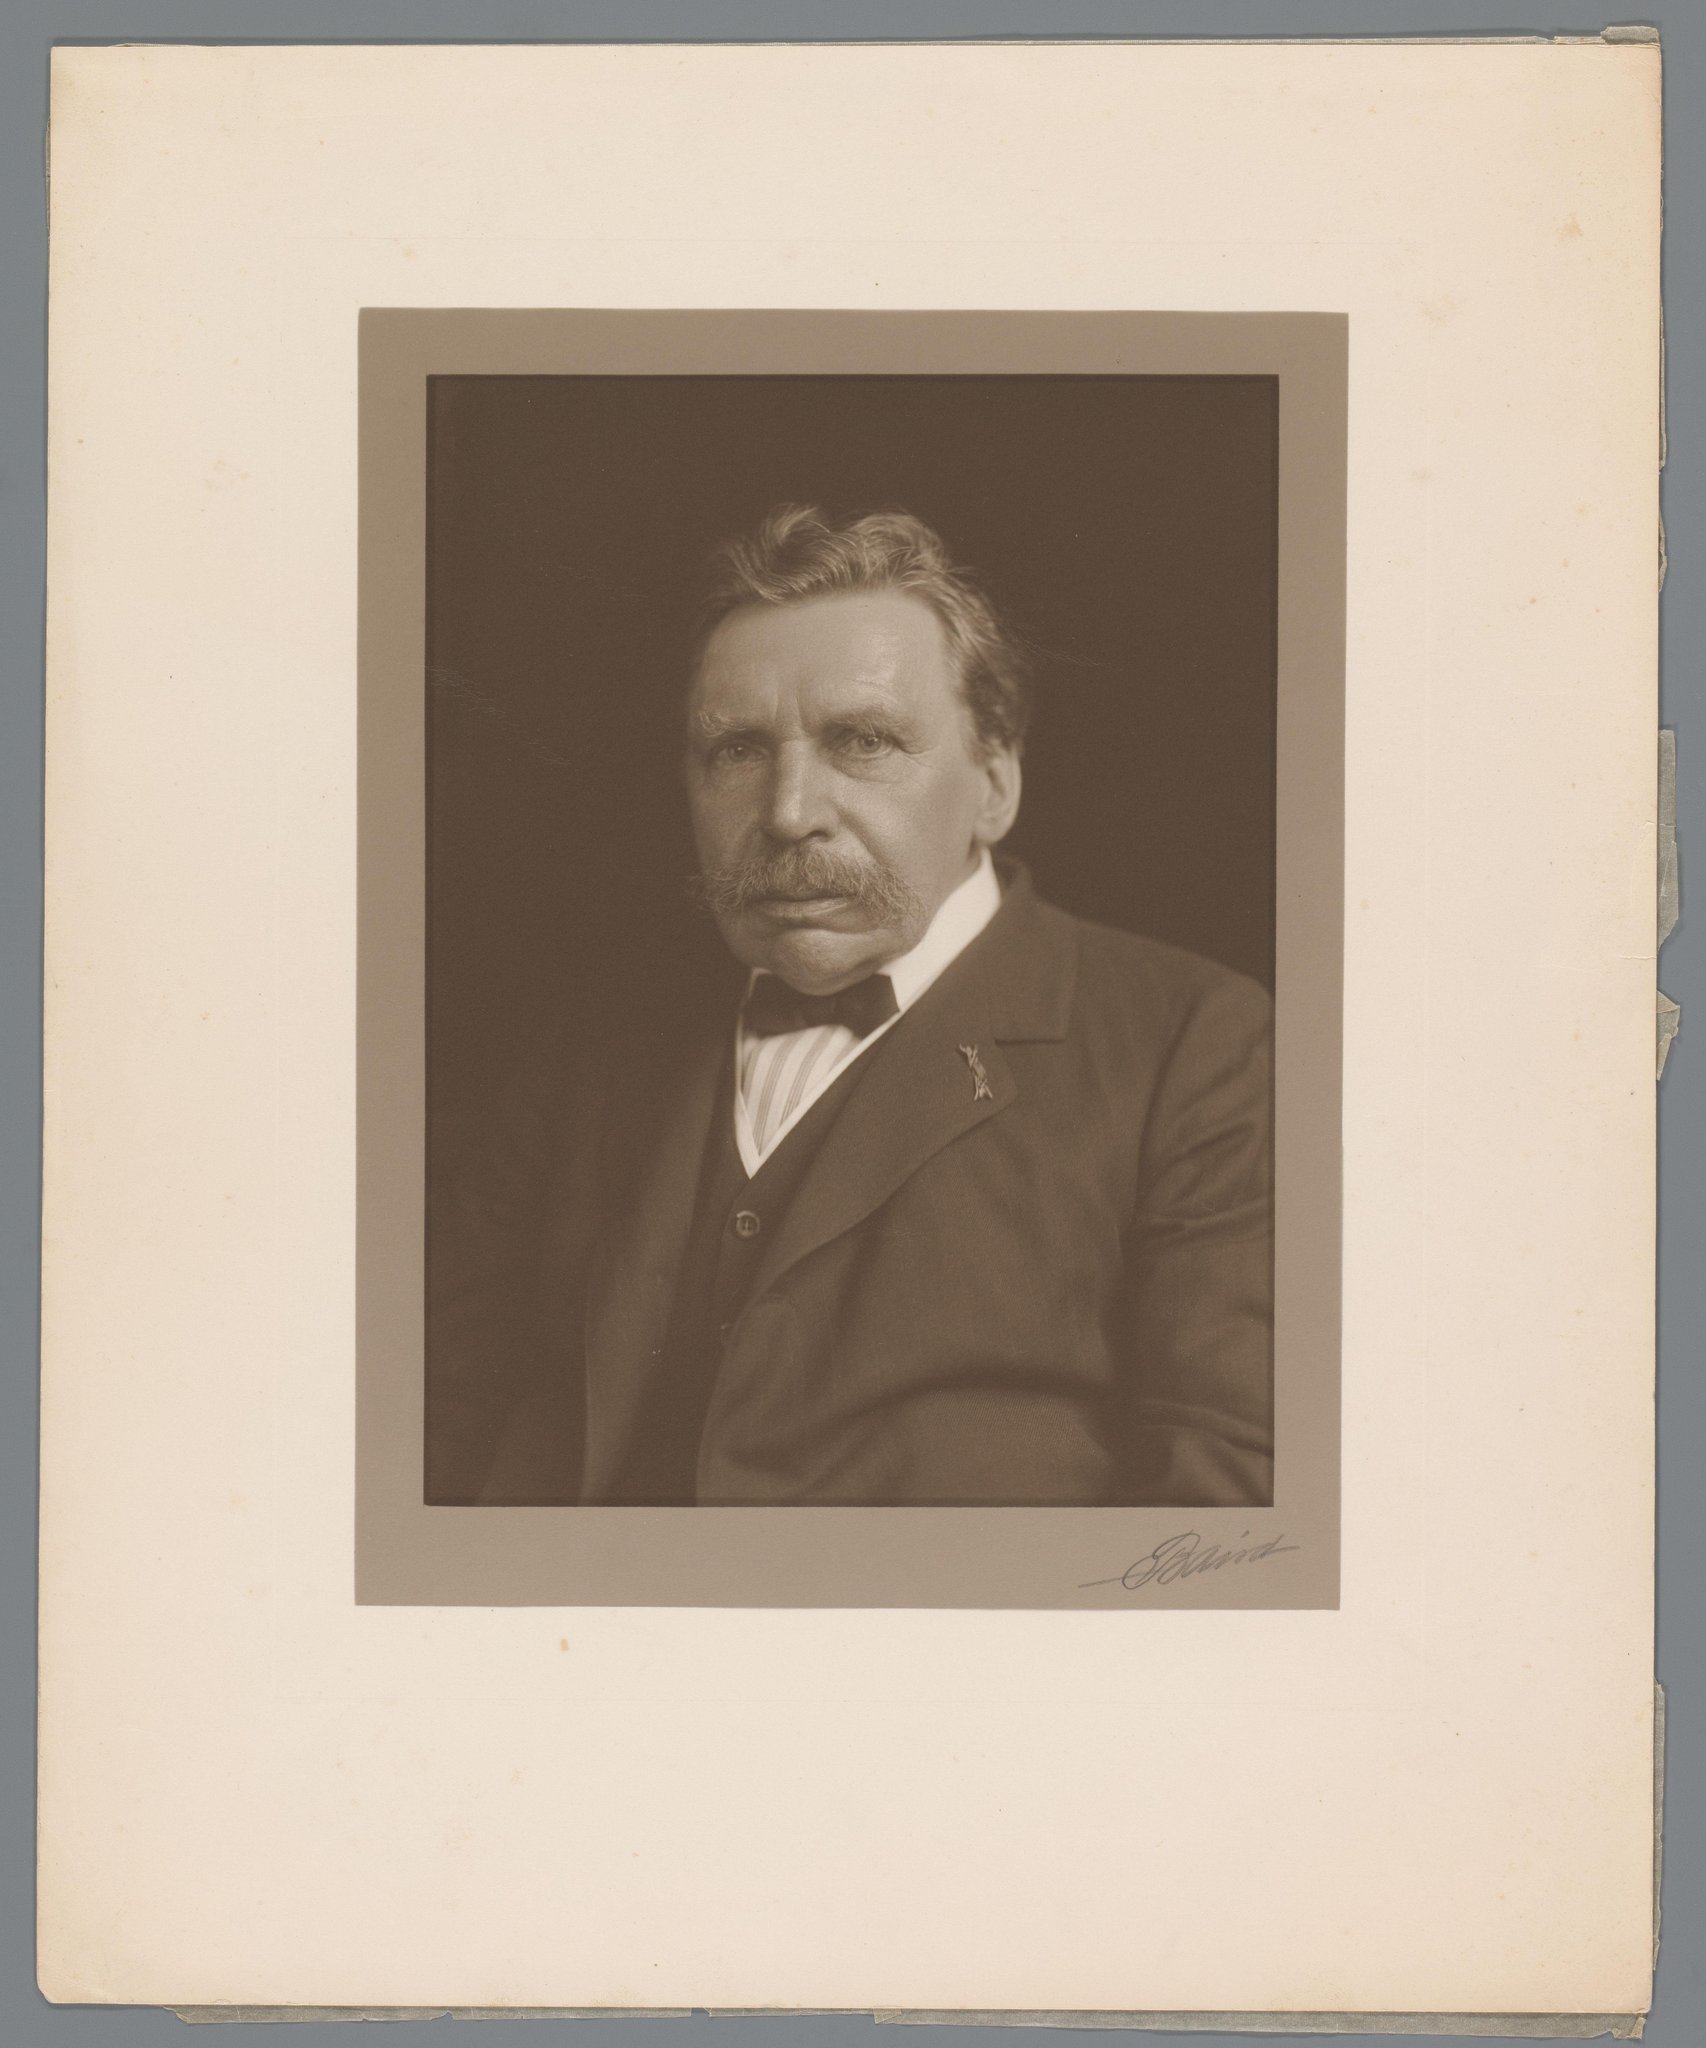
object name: photograph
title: Portret van Albert Neuhuys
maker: Anonymous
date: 1880-1914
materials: paper, photographic support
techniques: matte daylight collodion silver print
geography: netherlands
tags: utrecht, painter, print maker, draughtsman, albert neuhuys (1844-1914)